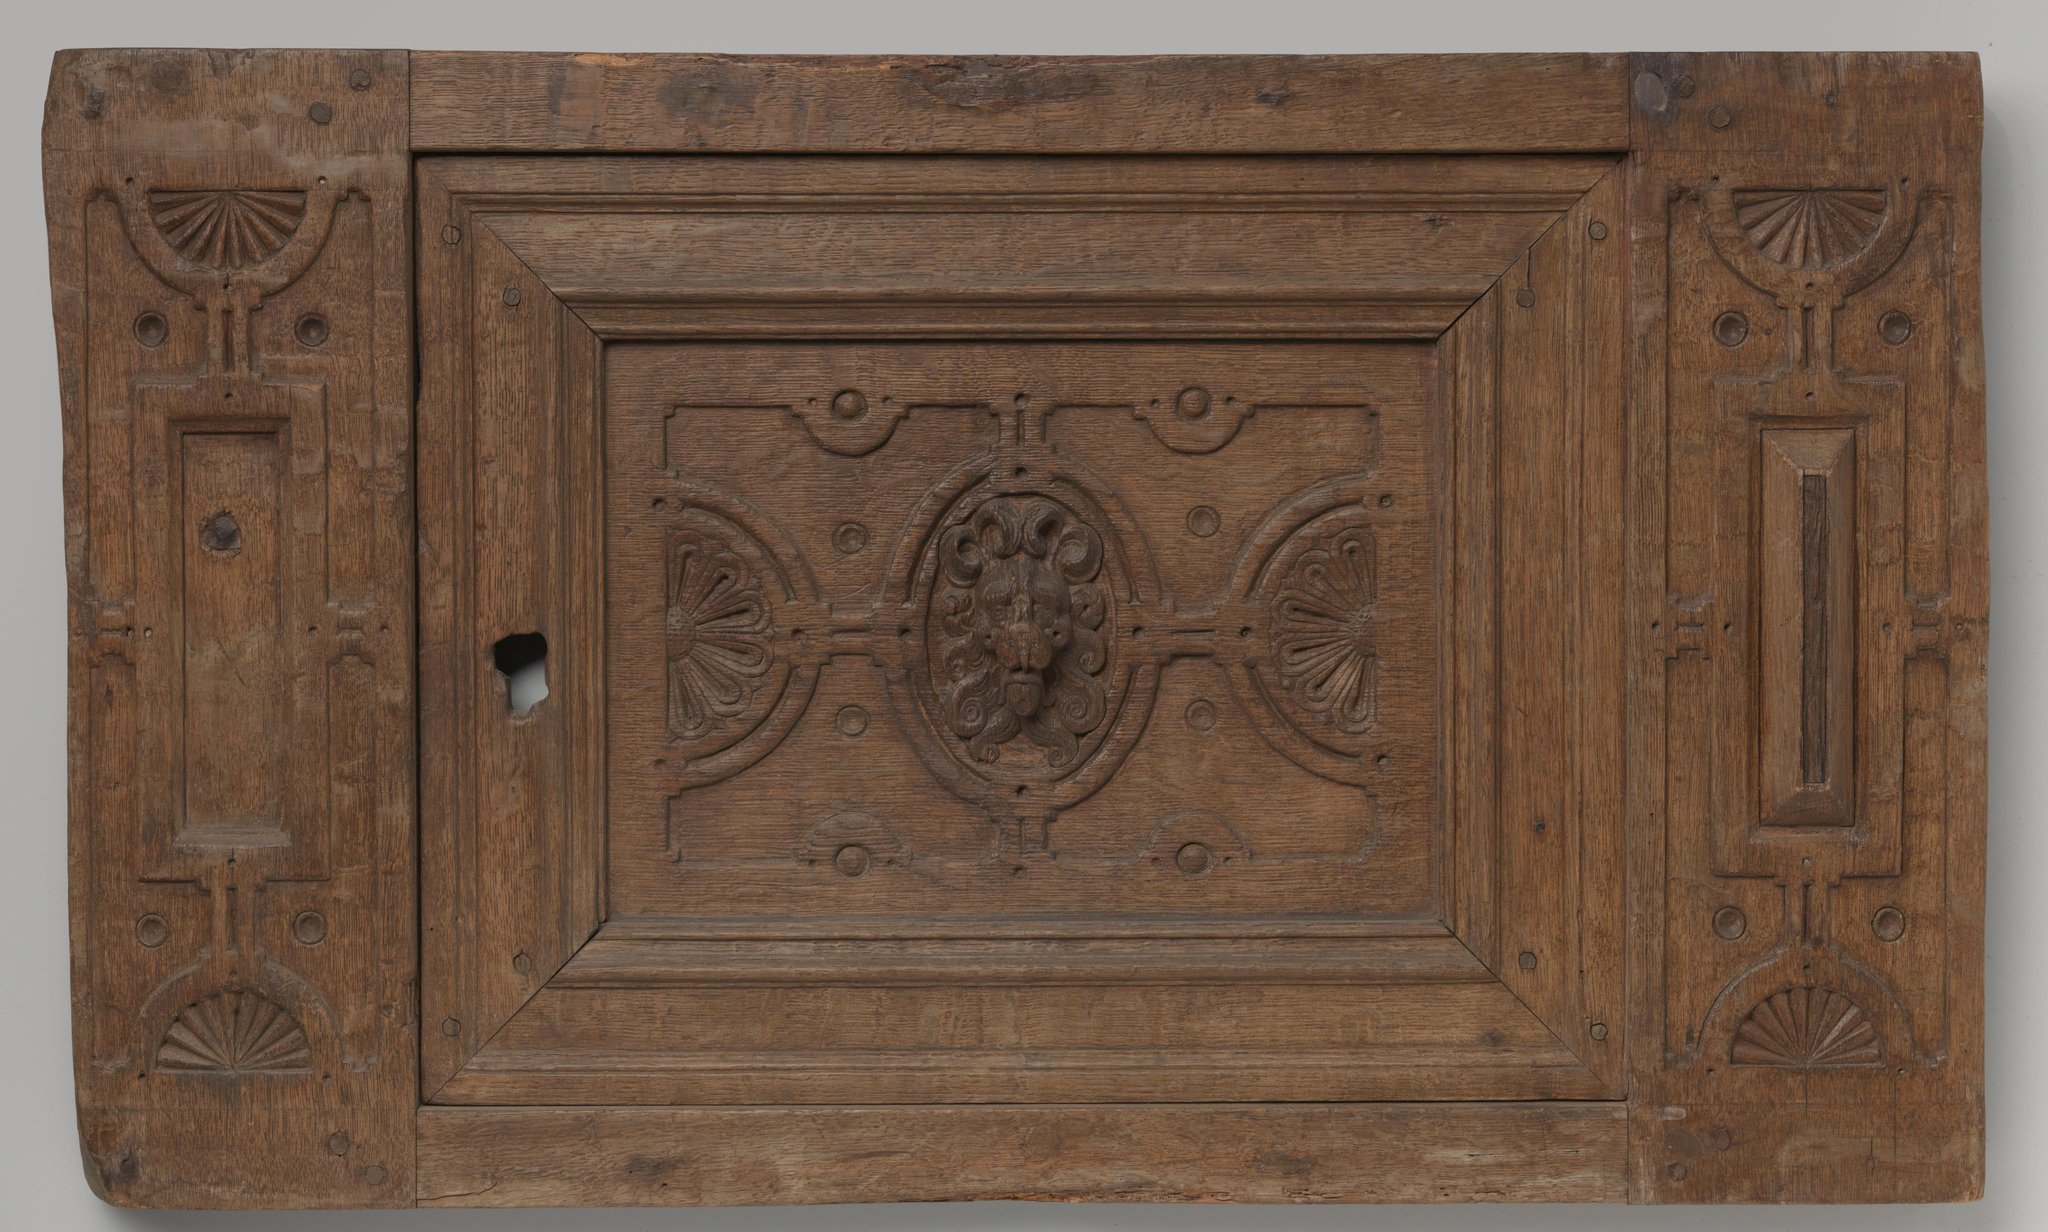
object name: case furniture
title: Muurkast, de deur gedecoreerd met gestoken leeuwenkop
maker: Anonymous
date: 1600-1650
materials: wood, paint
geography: netherlands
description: Muurkast van eikenhout. De deur is gedecoreerd met een gestoken leeuwenkop.